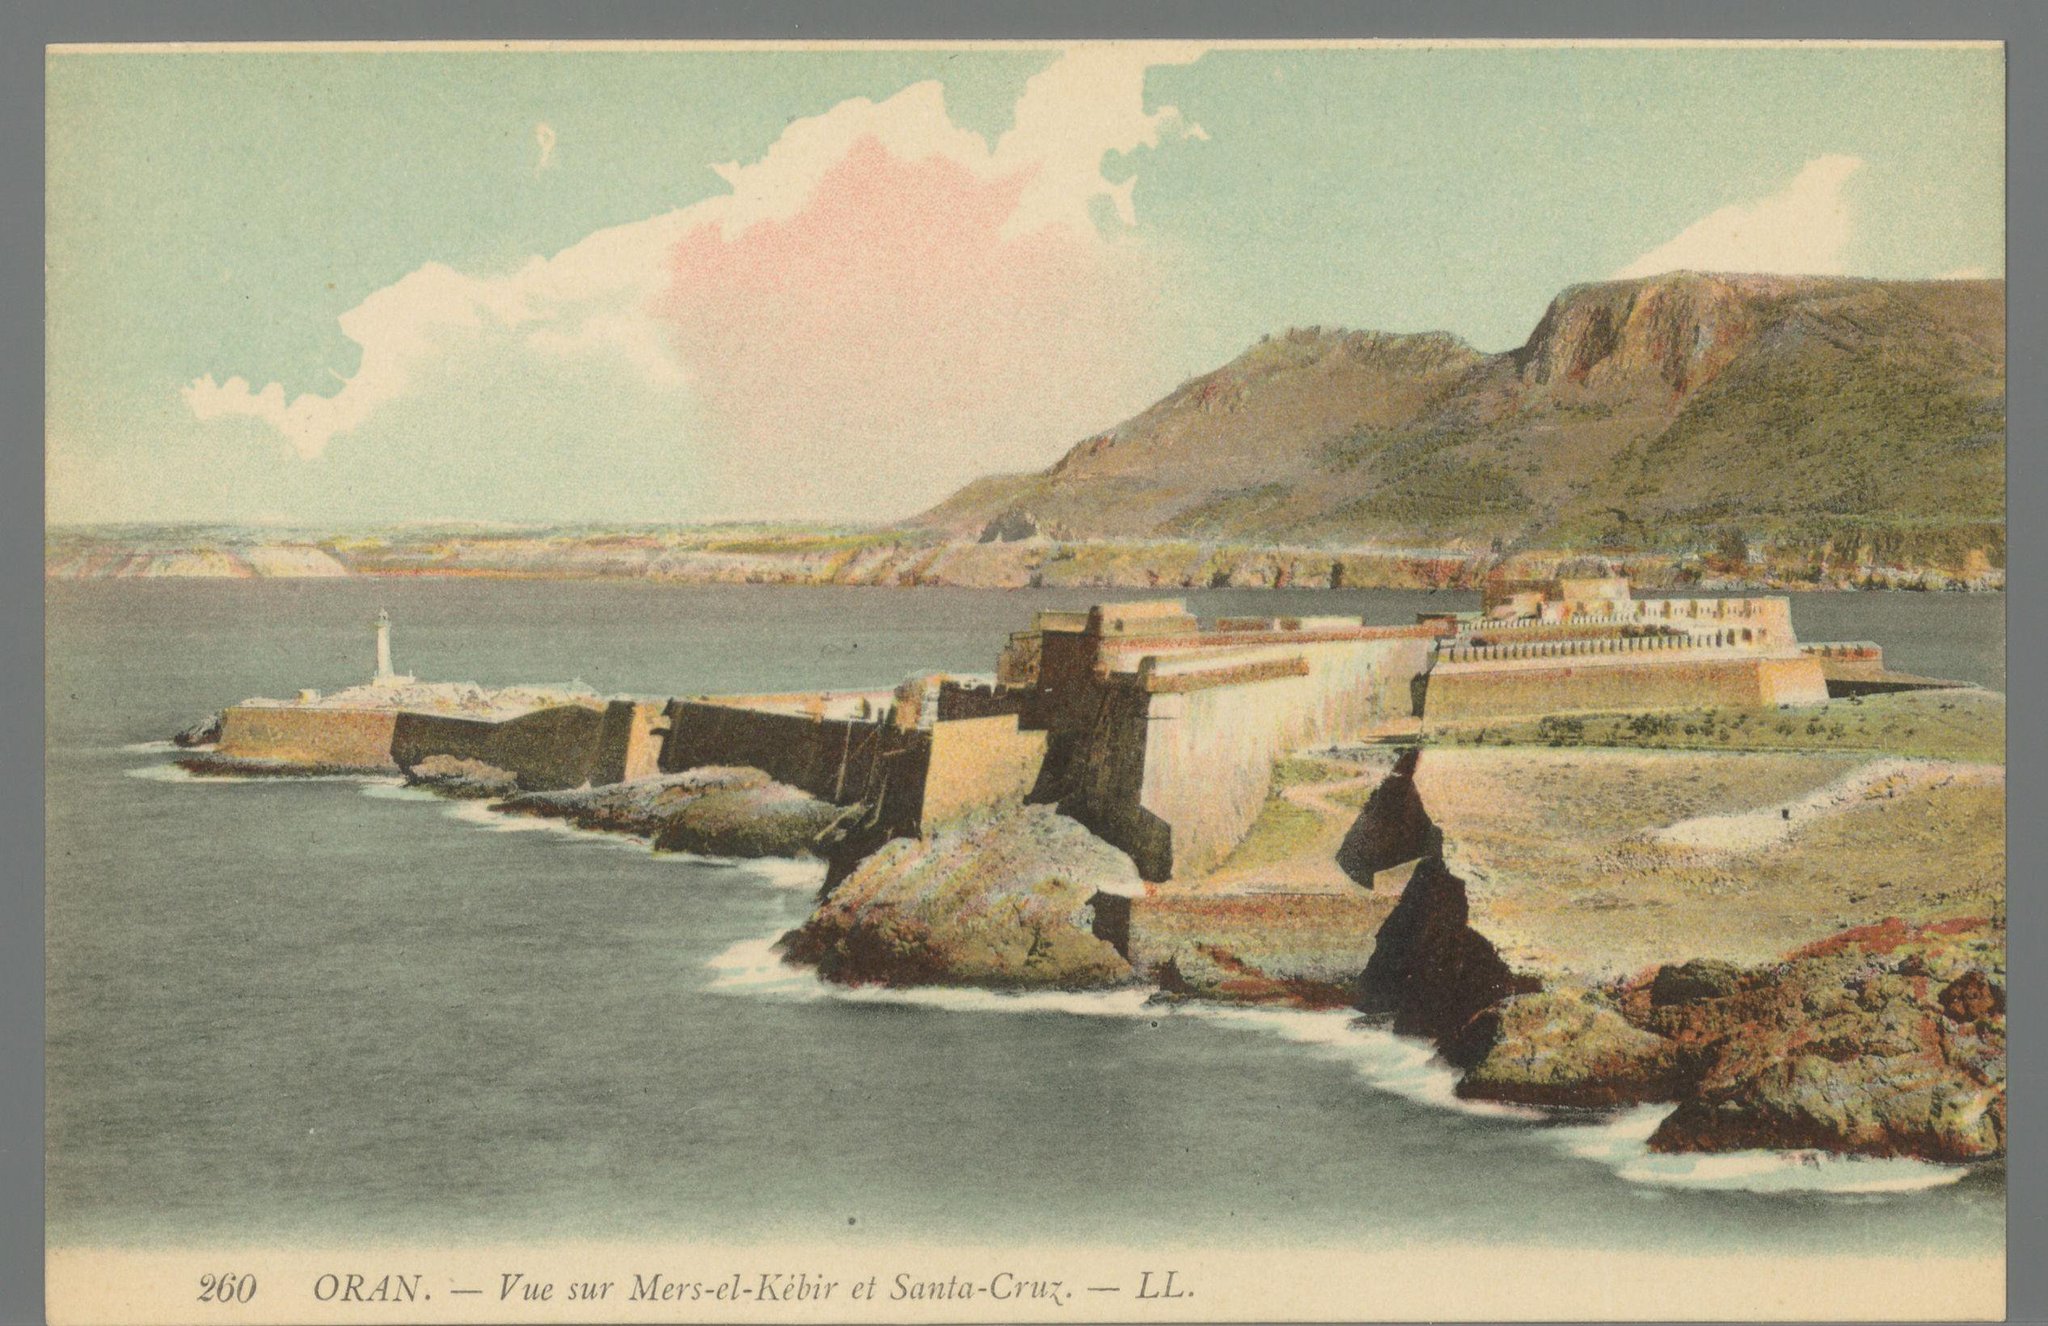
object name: photomechanical print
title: Oran. Vue sur Mers-el-Kébir et Santa-Cruz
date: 1903-1905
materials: cardboard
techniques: photograph, lithograph, writing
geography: paris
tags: fortifications, military engineering, coast (in tropical and sub-tropical regions)